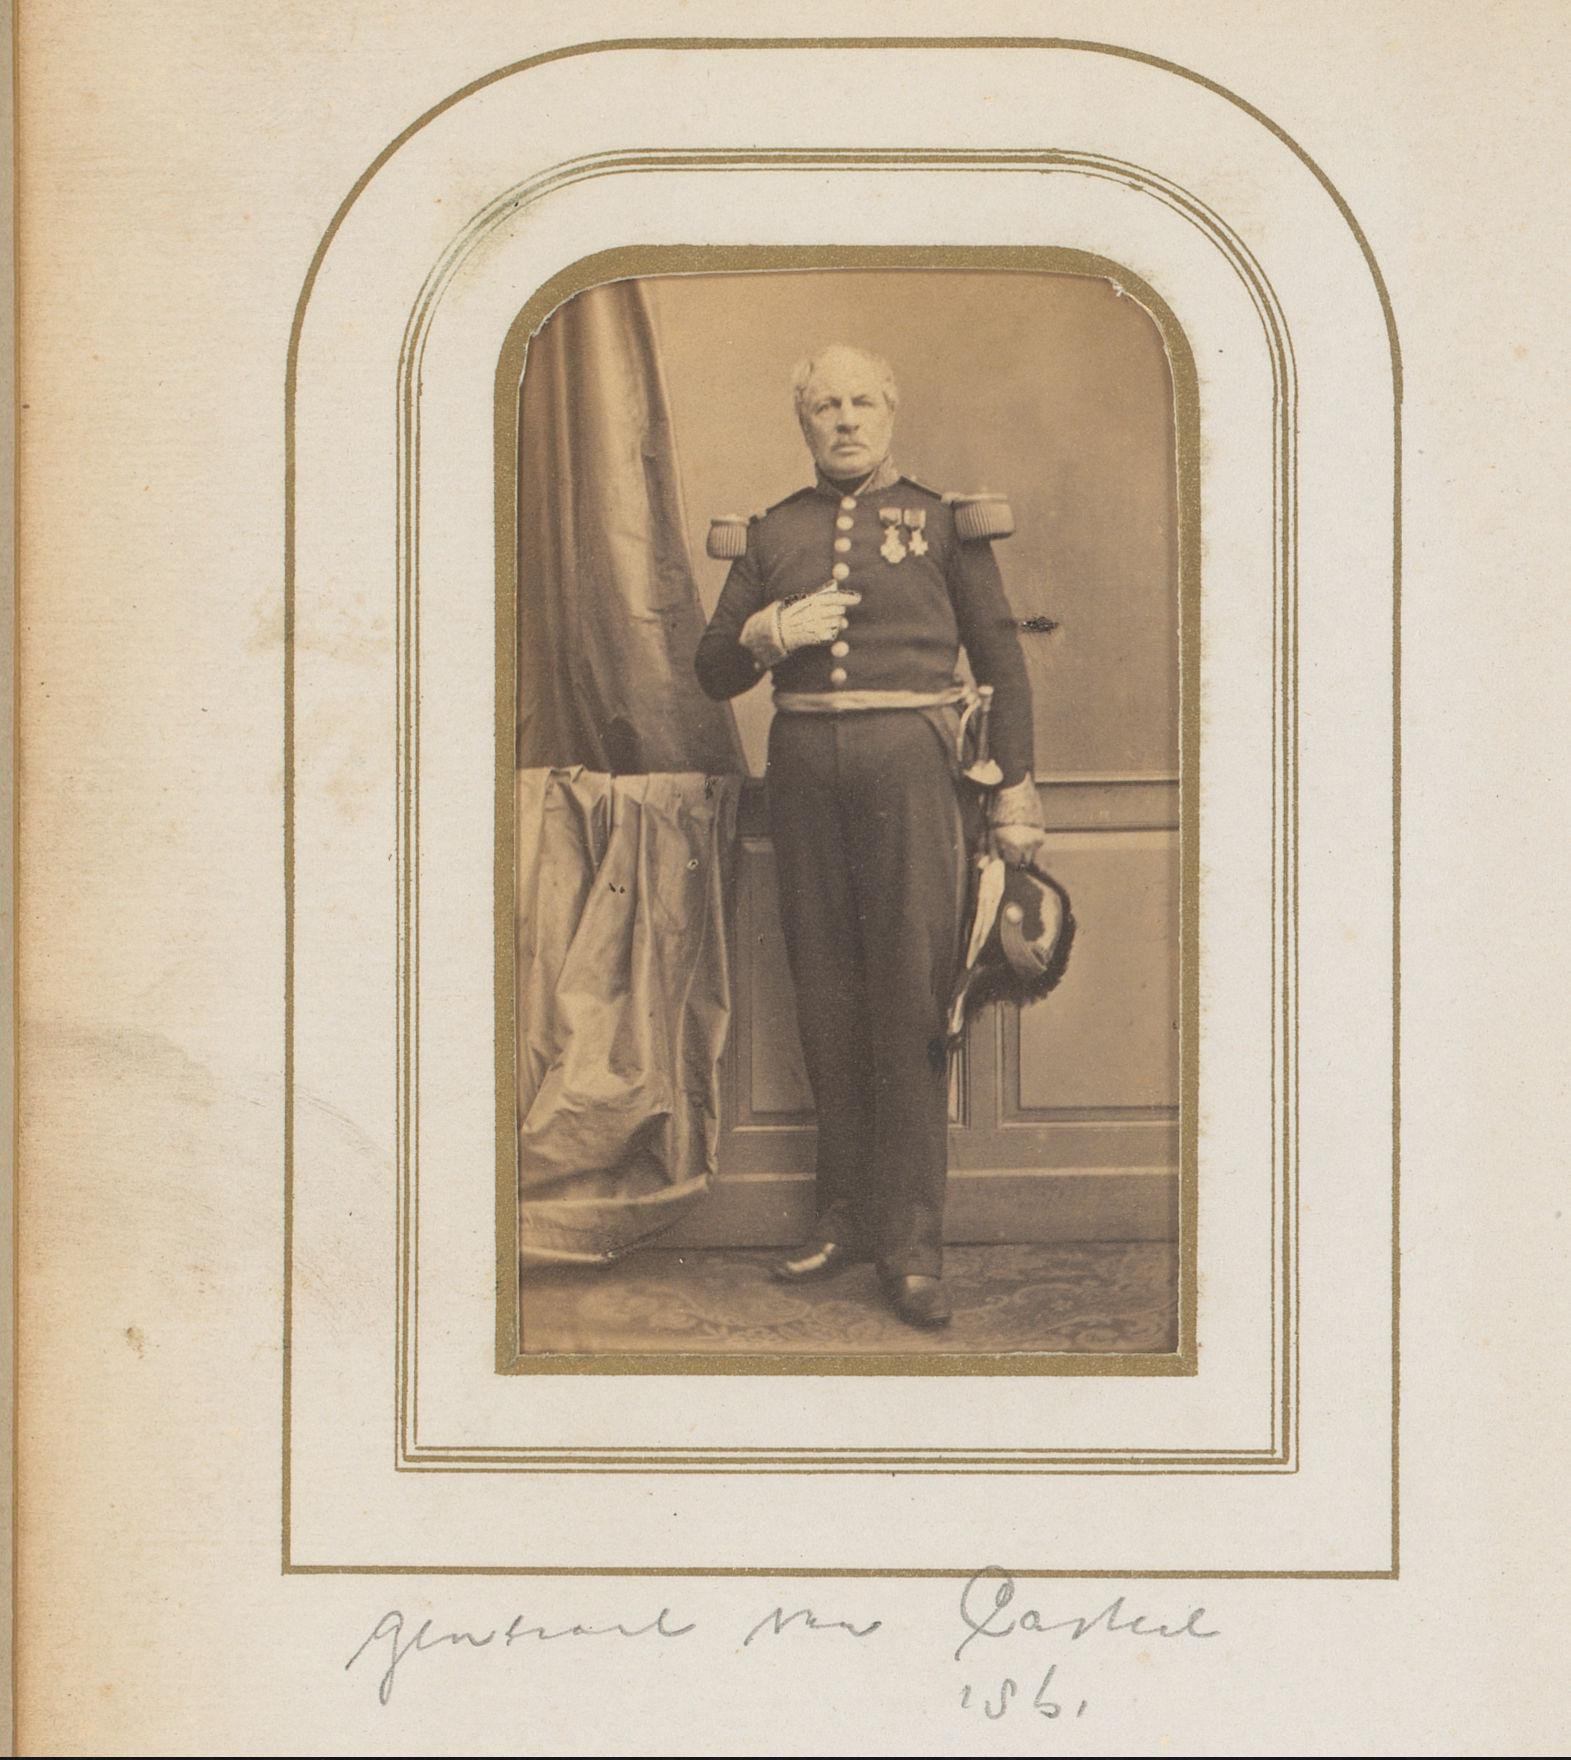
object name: album leaf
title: Portret van een man in uniform met medailles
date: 1860-1894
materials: cardboard, photographic support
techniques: albumen print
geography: brussels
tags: historical persons, medals and other marks of military honour, (military) uniforms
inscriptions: inscription: ‘Atelier de Photographie/ Ghémar Frères/ Photographes du roi/ 27, rue de l'Ecruyer/ entree par la porte cochère/ Bruxelles’